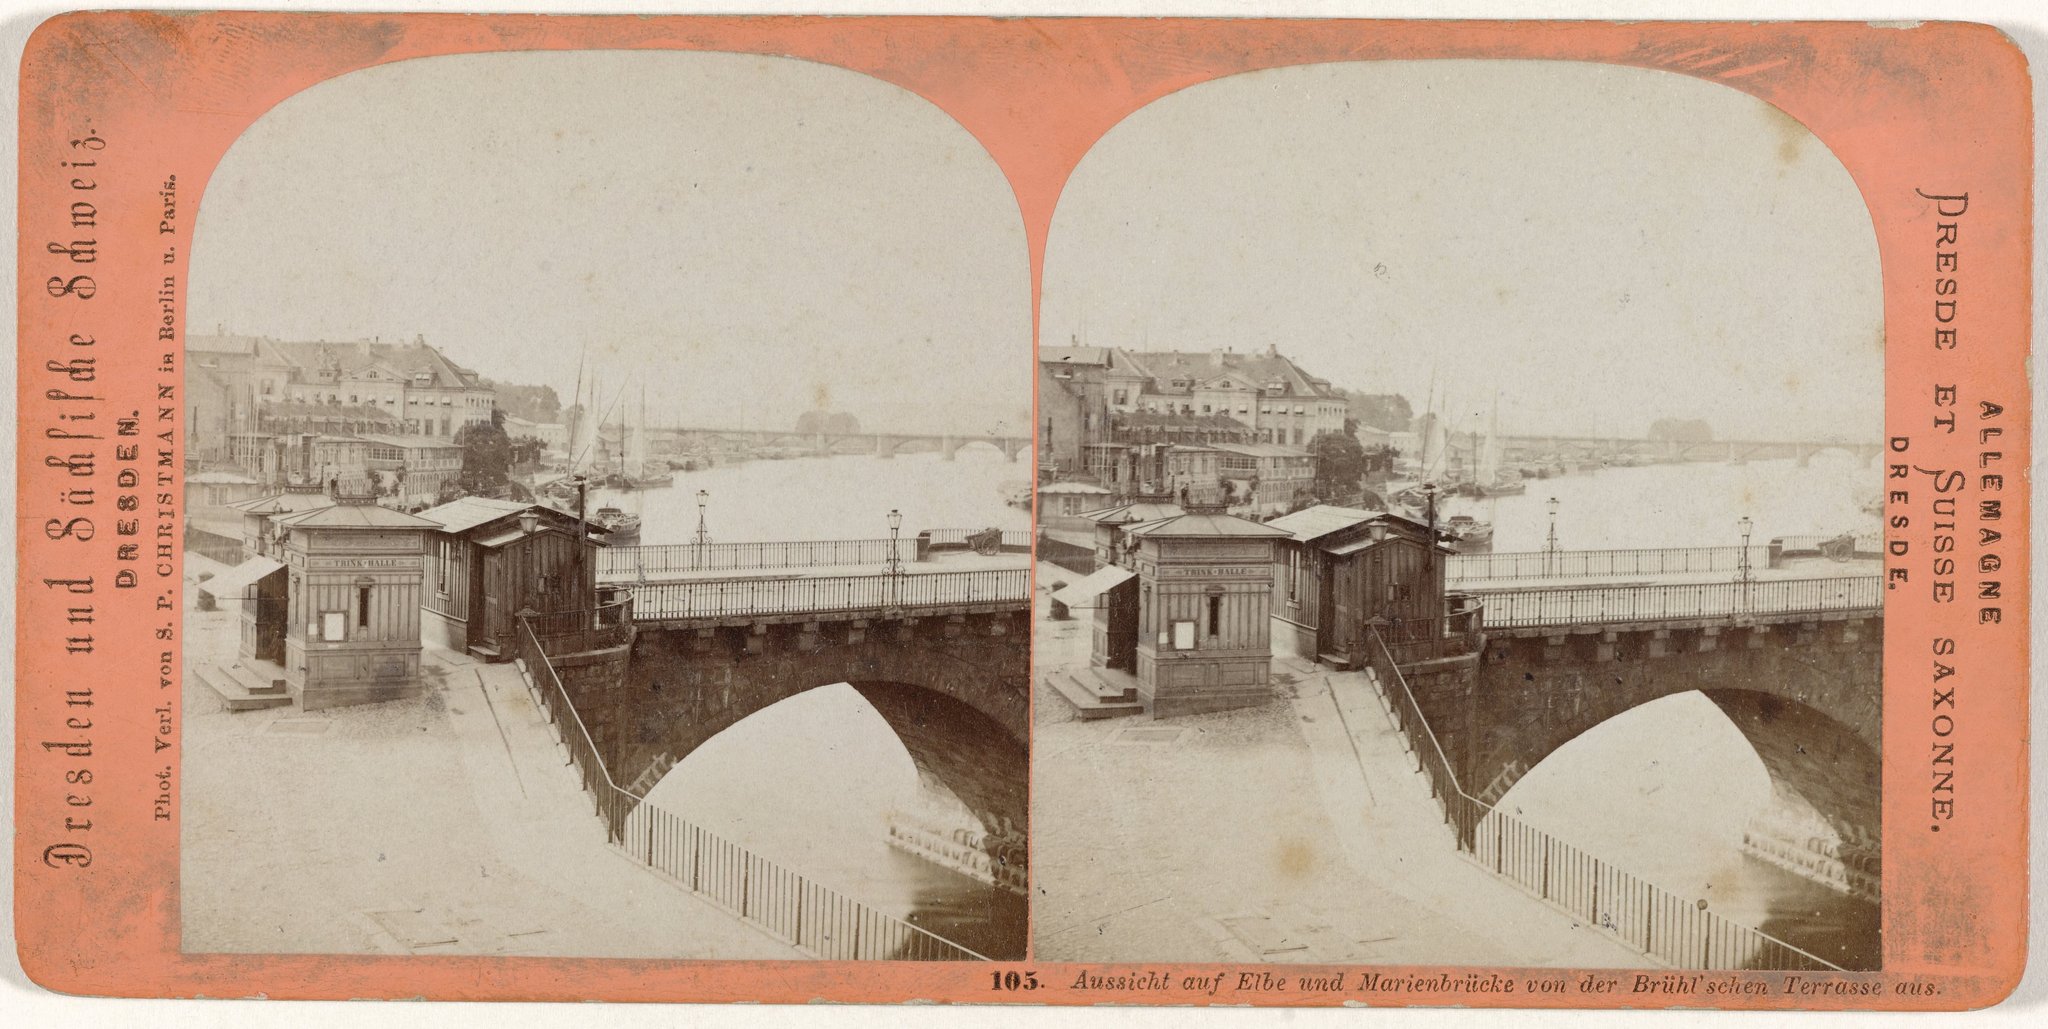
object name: stereograph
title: Dresden und Sächsische Schweiz, Dresden / Allemagne, Dresde et Suisse Saxone, Dresde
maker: s.p. christmann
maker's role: publisher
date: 1873-1890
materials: cardboard, paper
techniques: albumen print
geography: berlin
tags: bridge in city across river, canal, etc.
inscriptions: number: ‘105.’